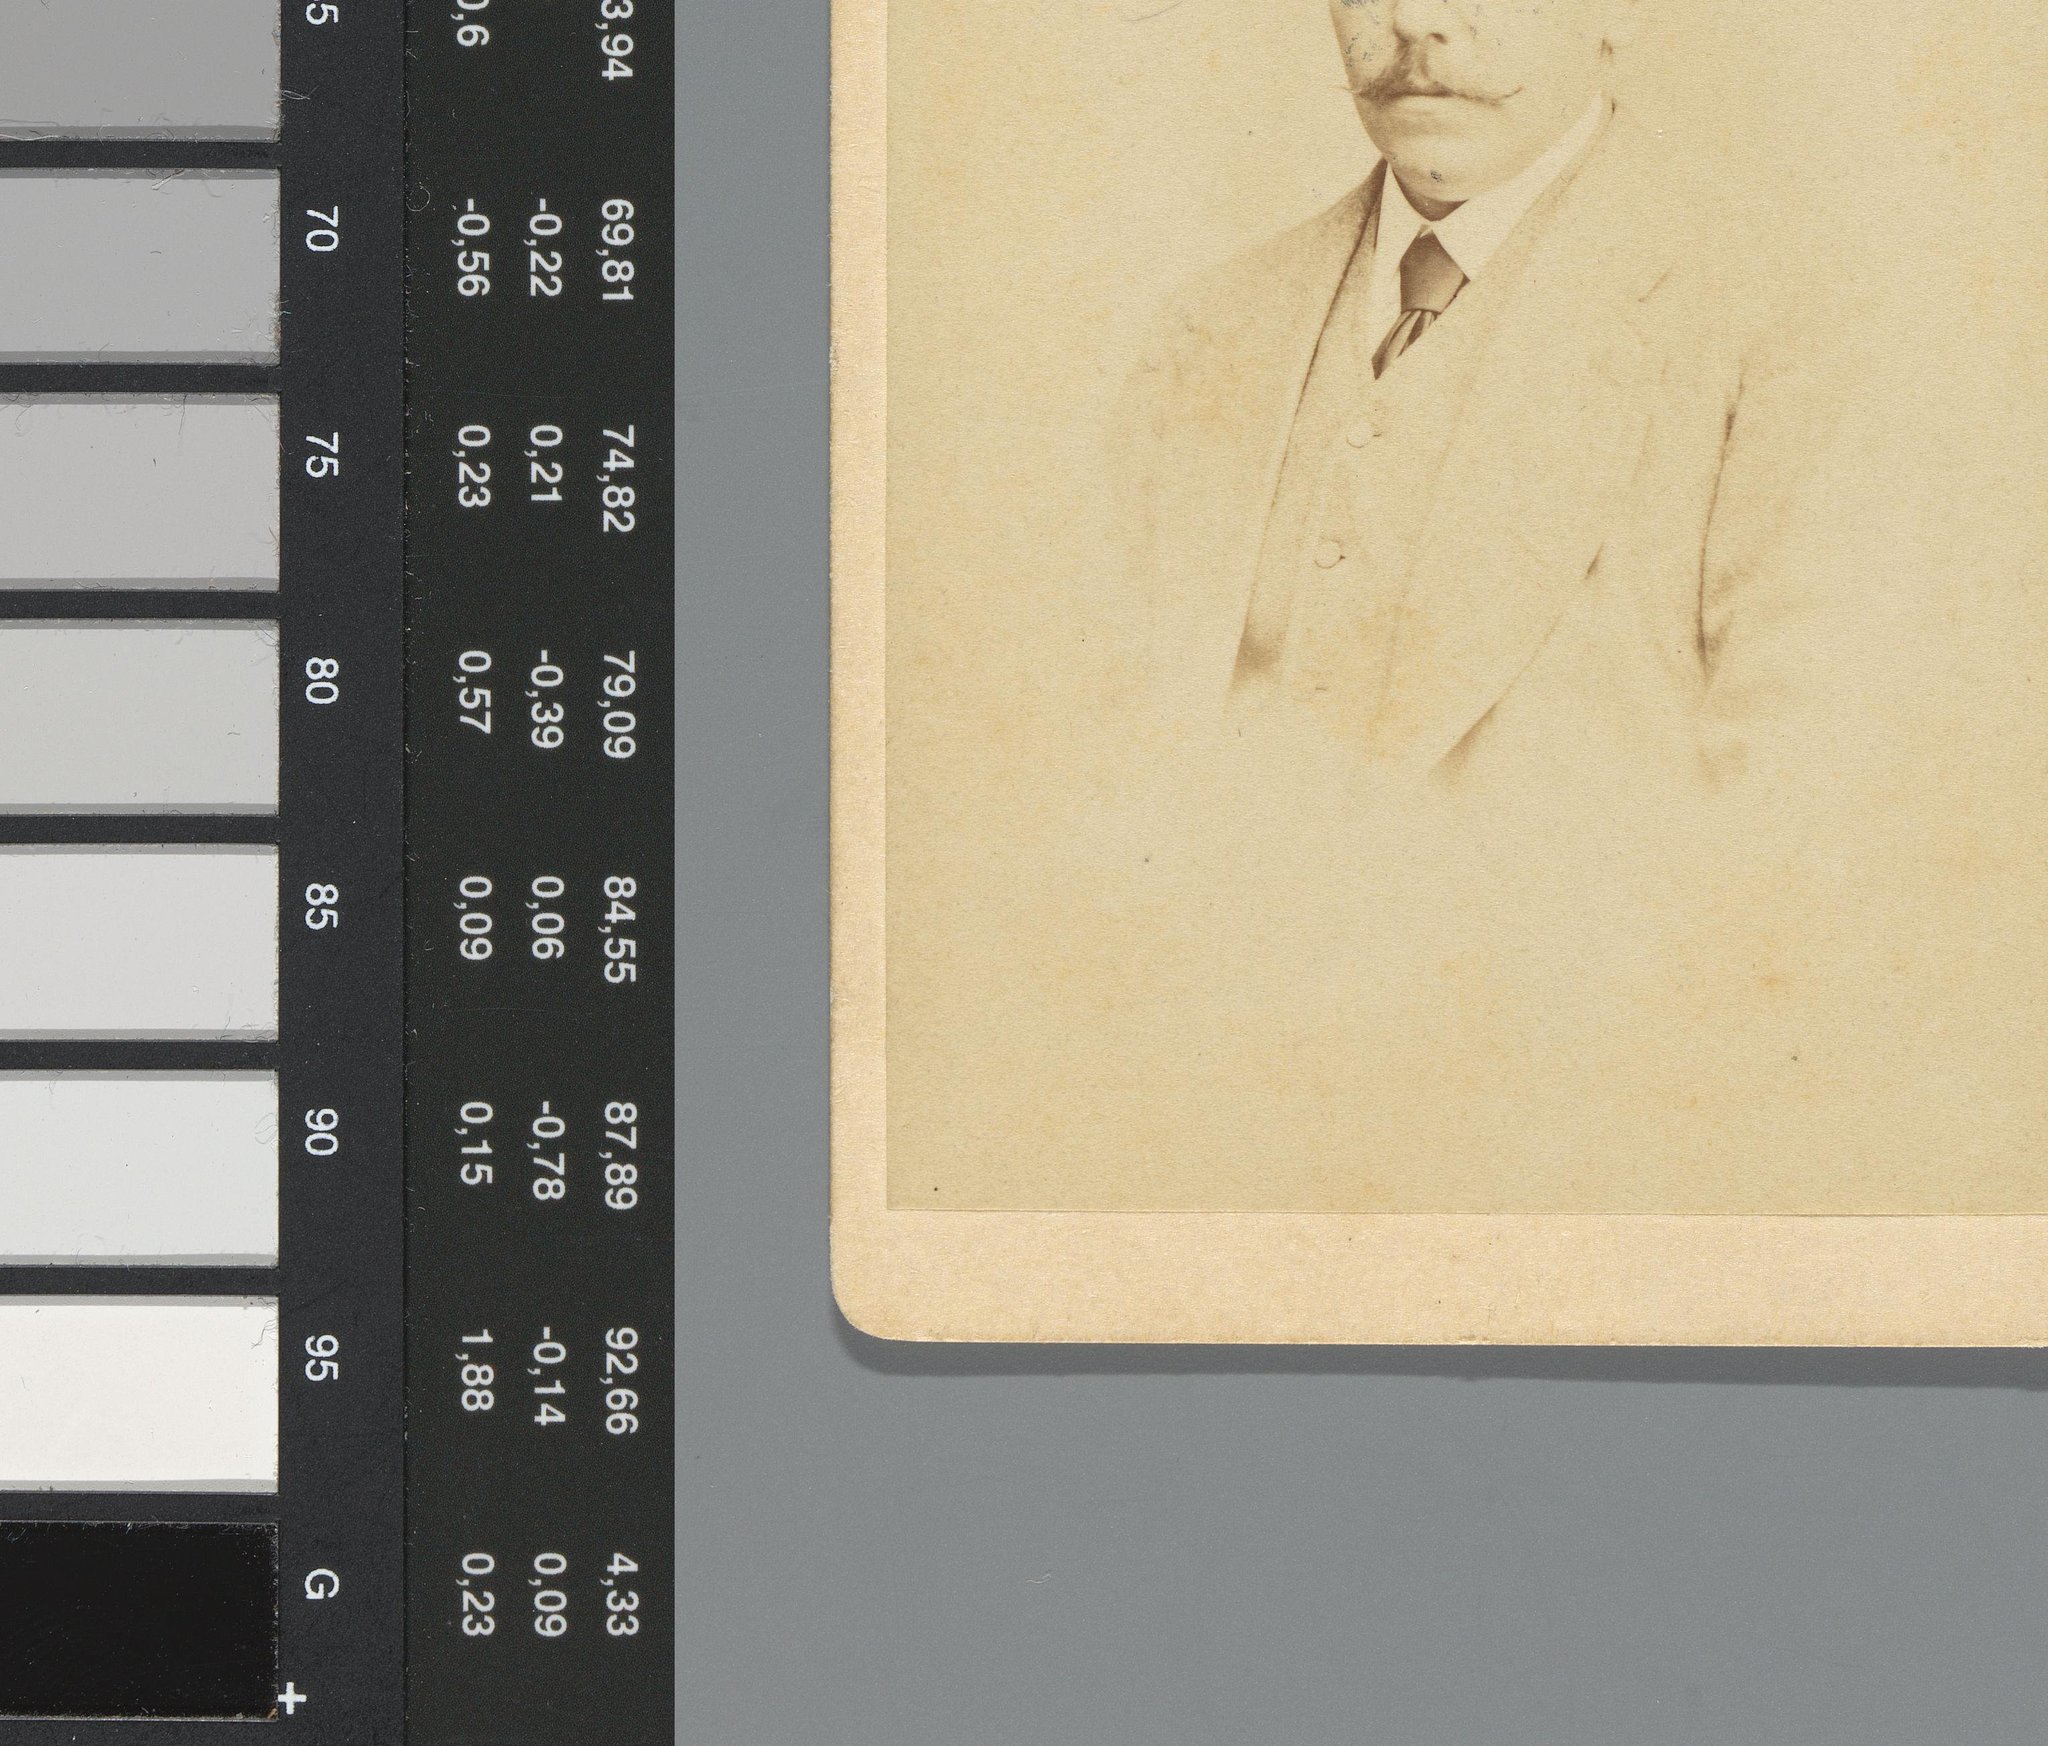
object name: photograph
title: Portret van Norbert van den Berg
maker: theodorus diepenbach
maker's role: fotograaf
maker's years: 1829-1940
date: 1855-1910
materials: cardboard, photographic support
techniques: albumen print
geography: cleves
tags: rotterdam, norbertus petrus van den berg (1831-1917)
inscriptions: name: ‘TH. DIEPENBACH / Photograph, / 554 KURZE MARKTSTRASSE 554. / CLEVE.’, inscription: ‘Platte ist für Nachbestellungen aufbewahrt’